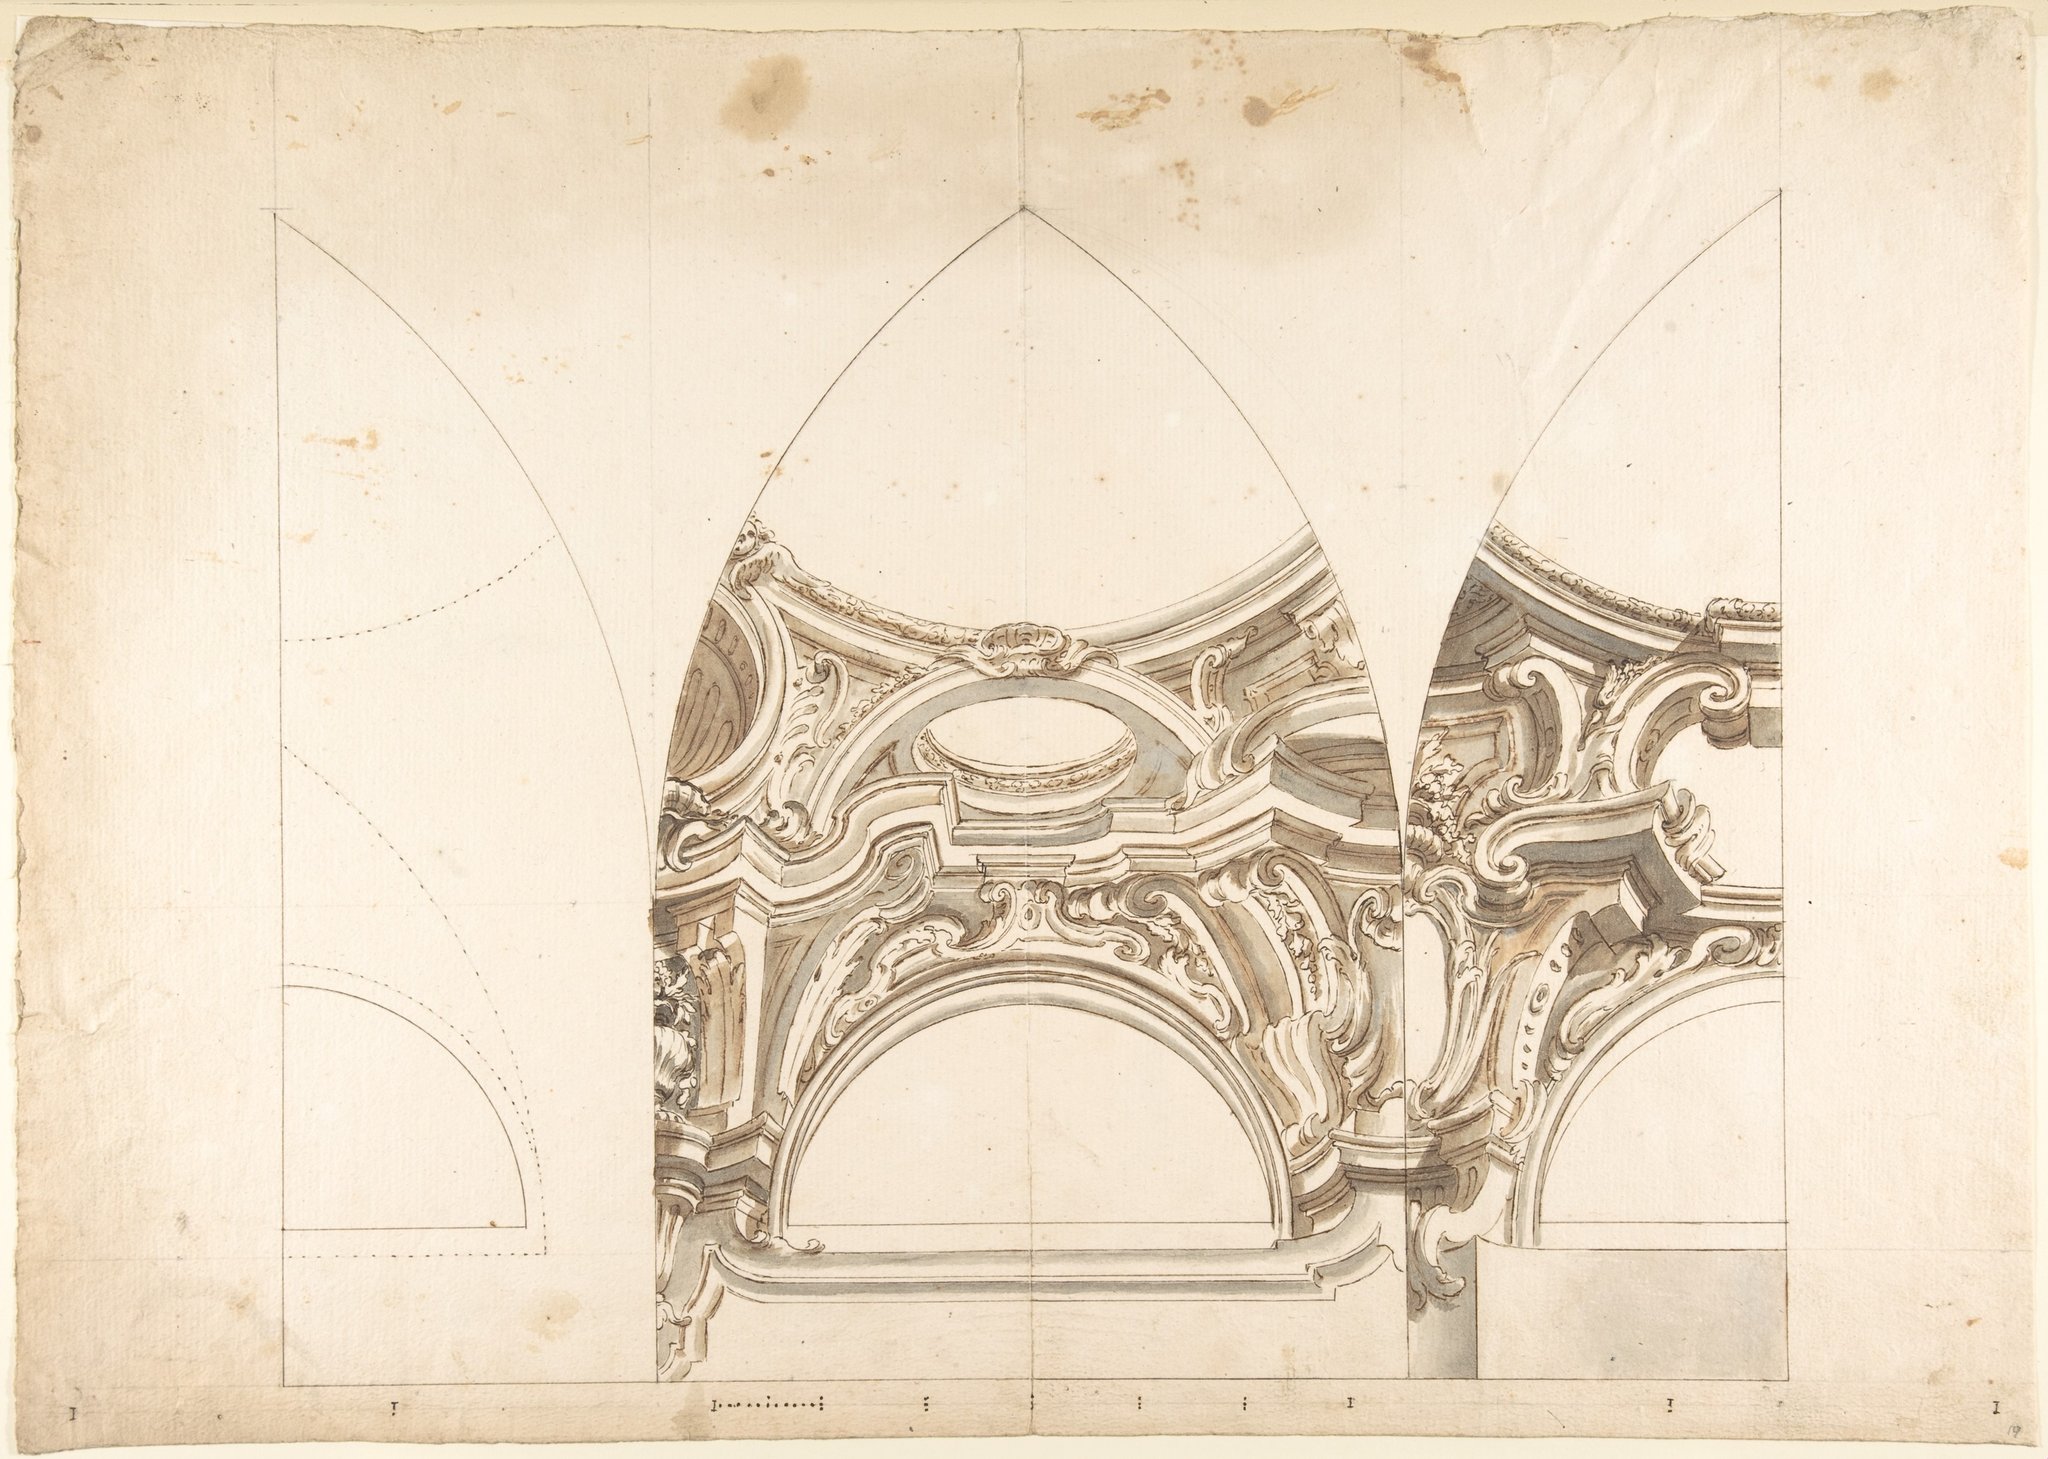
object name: drawing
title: Three Designs for the Ornamentation of Vaults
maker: anonymous, italian, piedmontese, 18th century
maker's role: artist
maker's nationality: italian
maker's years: 1700-1800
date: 1700-1780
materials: graphite, ink, drawing material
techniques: brush, pen, wash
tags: architecture